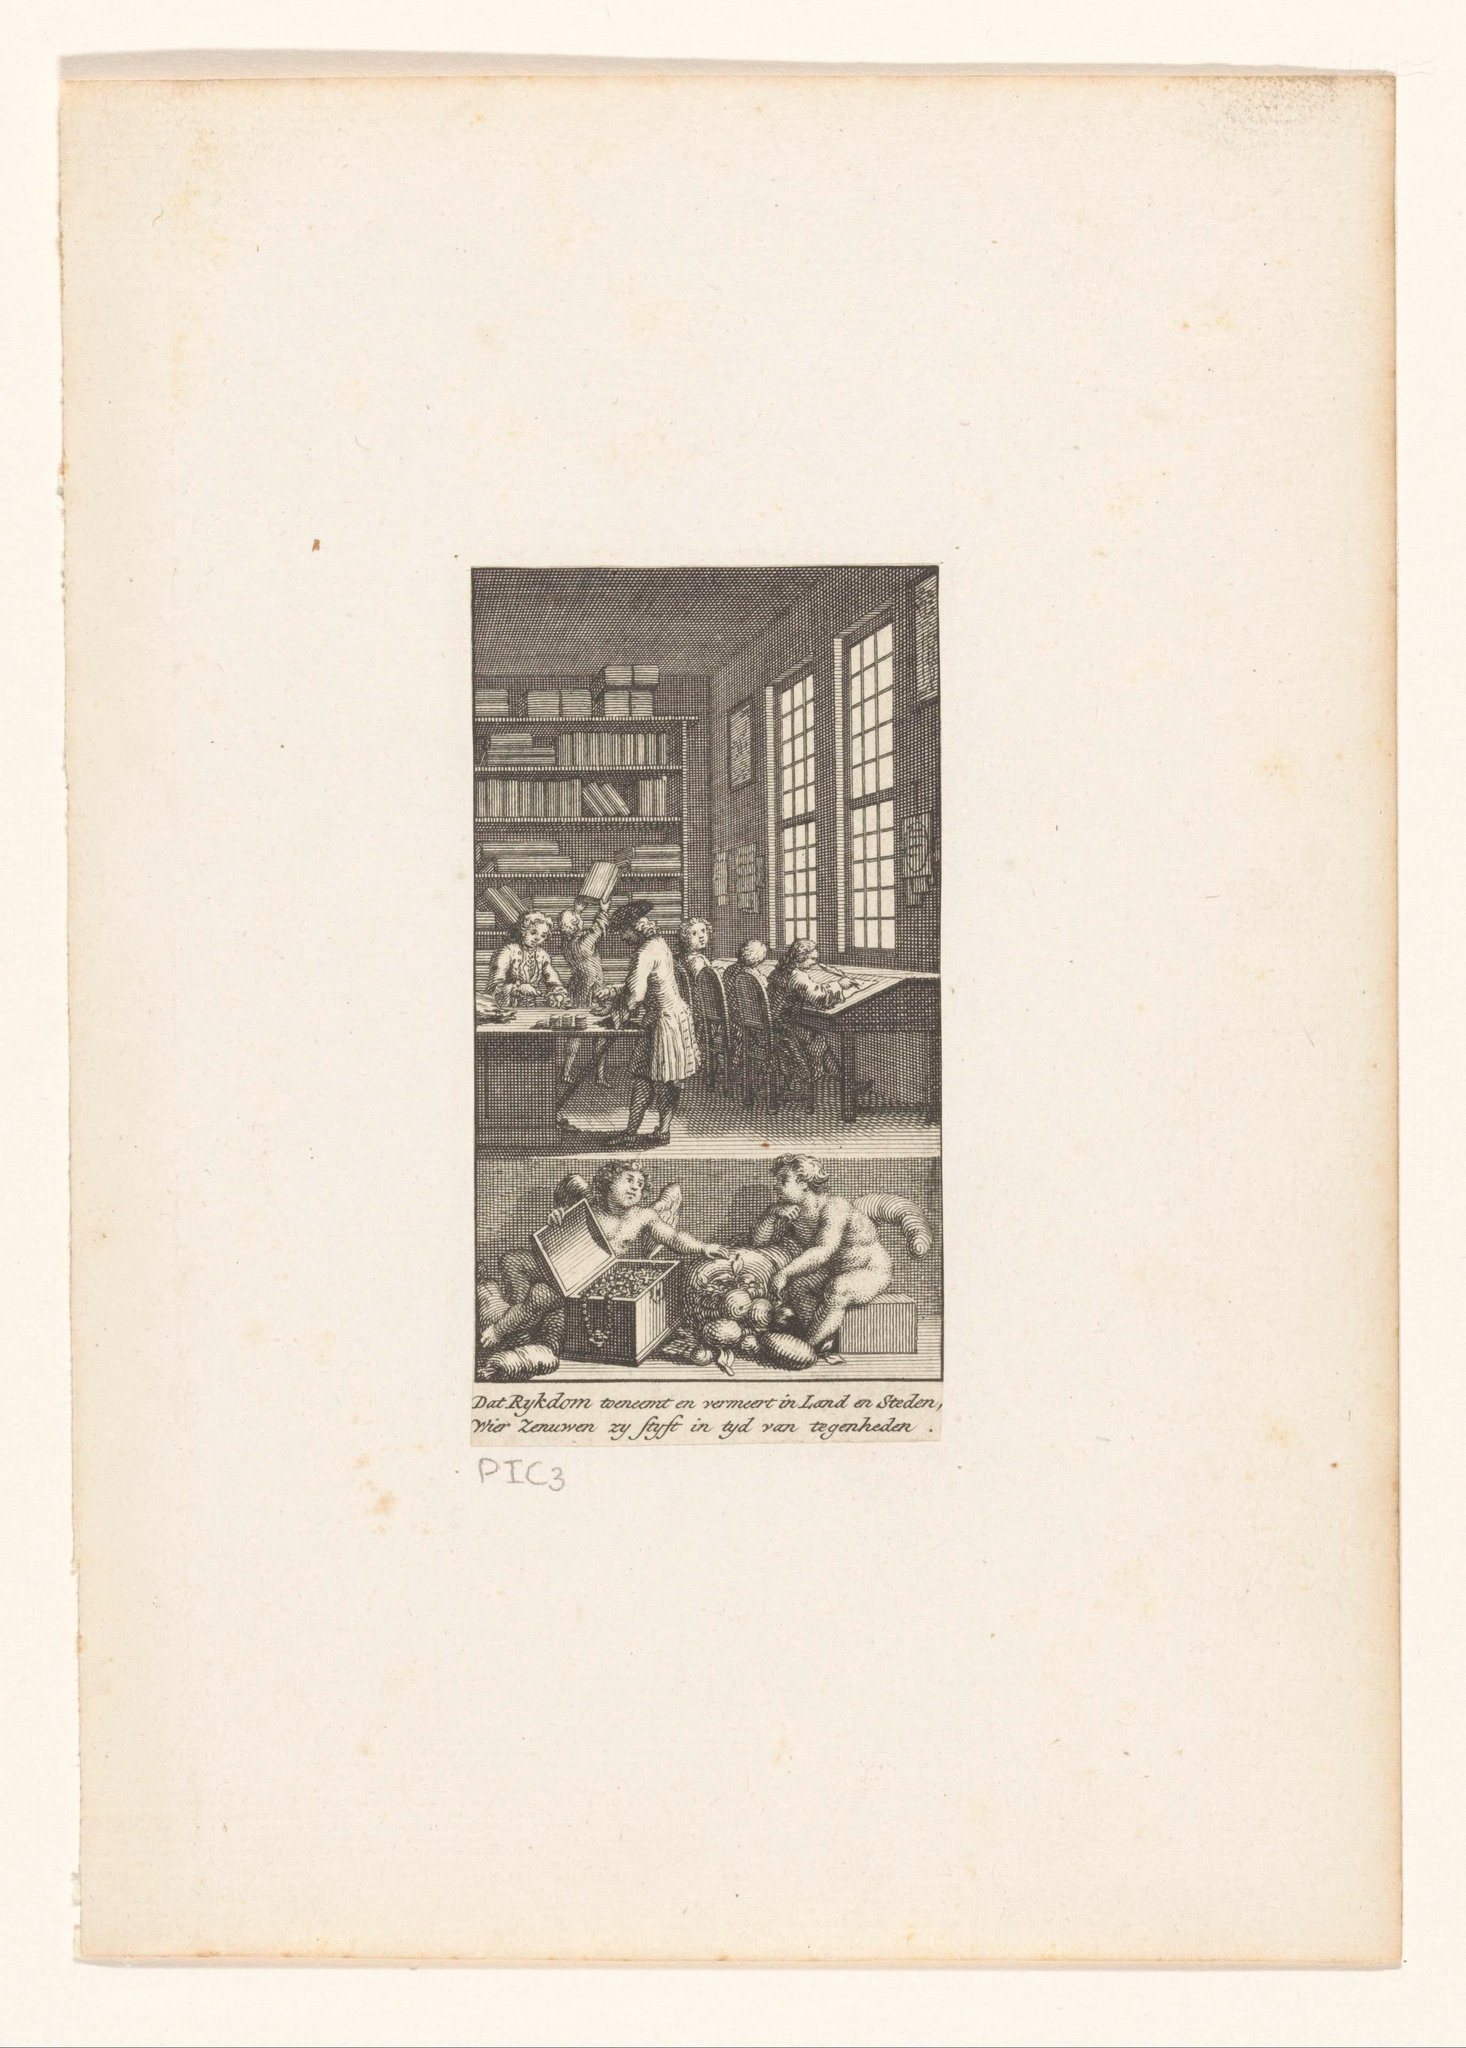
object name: print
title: Boekhandel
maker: Anonymous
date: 1700-1799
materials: paper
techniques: engraving, etching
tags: 'cornucopia', horn of plenty, cupids: 'amores', 'amoretti', 'putti', book-shop, bookseller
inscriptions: collector's mark: Lugt 2228, collector's mark: Lugt 4780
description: Interieur van een boekhandel met een klant die afrekent en drie personen aan een schrijftafel voor het raam. Daaronder twee putti met een schatkist en een Hoorn des overvloeds.